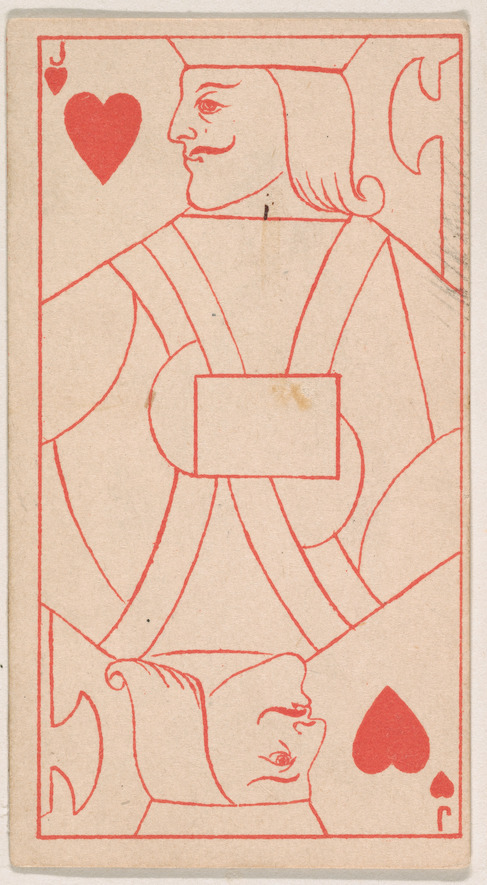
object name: print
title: Jack of Hearts, from the Transparent Playing Cards series (N220) issued by Kinney Bros.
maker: kinney brothers tobacco company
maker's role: publisher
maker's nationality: american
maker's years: 1869-2011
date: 1888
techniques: color lithograph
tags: playing cards